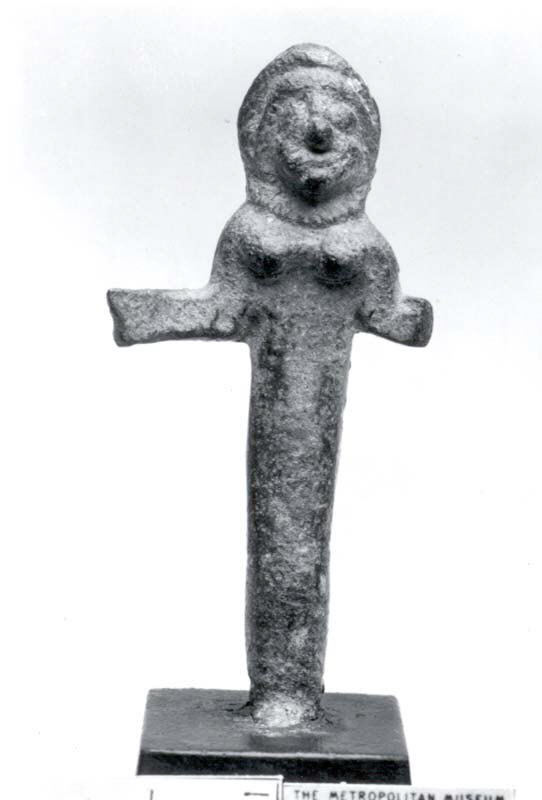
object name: sculpture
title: Figurine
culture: canaanite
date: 1500 BCE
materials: bronze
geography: syria